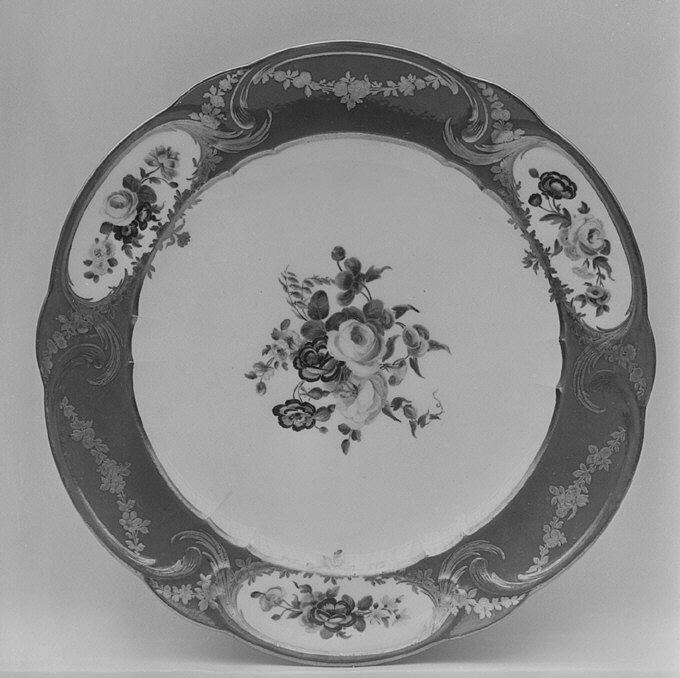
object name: plate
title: Plate (Assiette à palmes) (1 of 102) (part of a service)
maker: sèvres manufactory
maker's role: manufactory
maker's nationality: french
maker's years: 1740-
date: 1772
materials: soft paste porcelain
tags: flowers